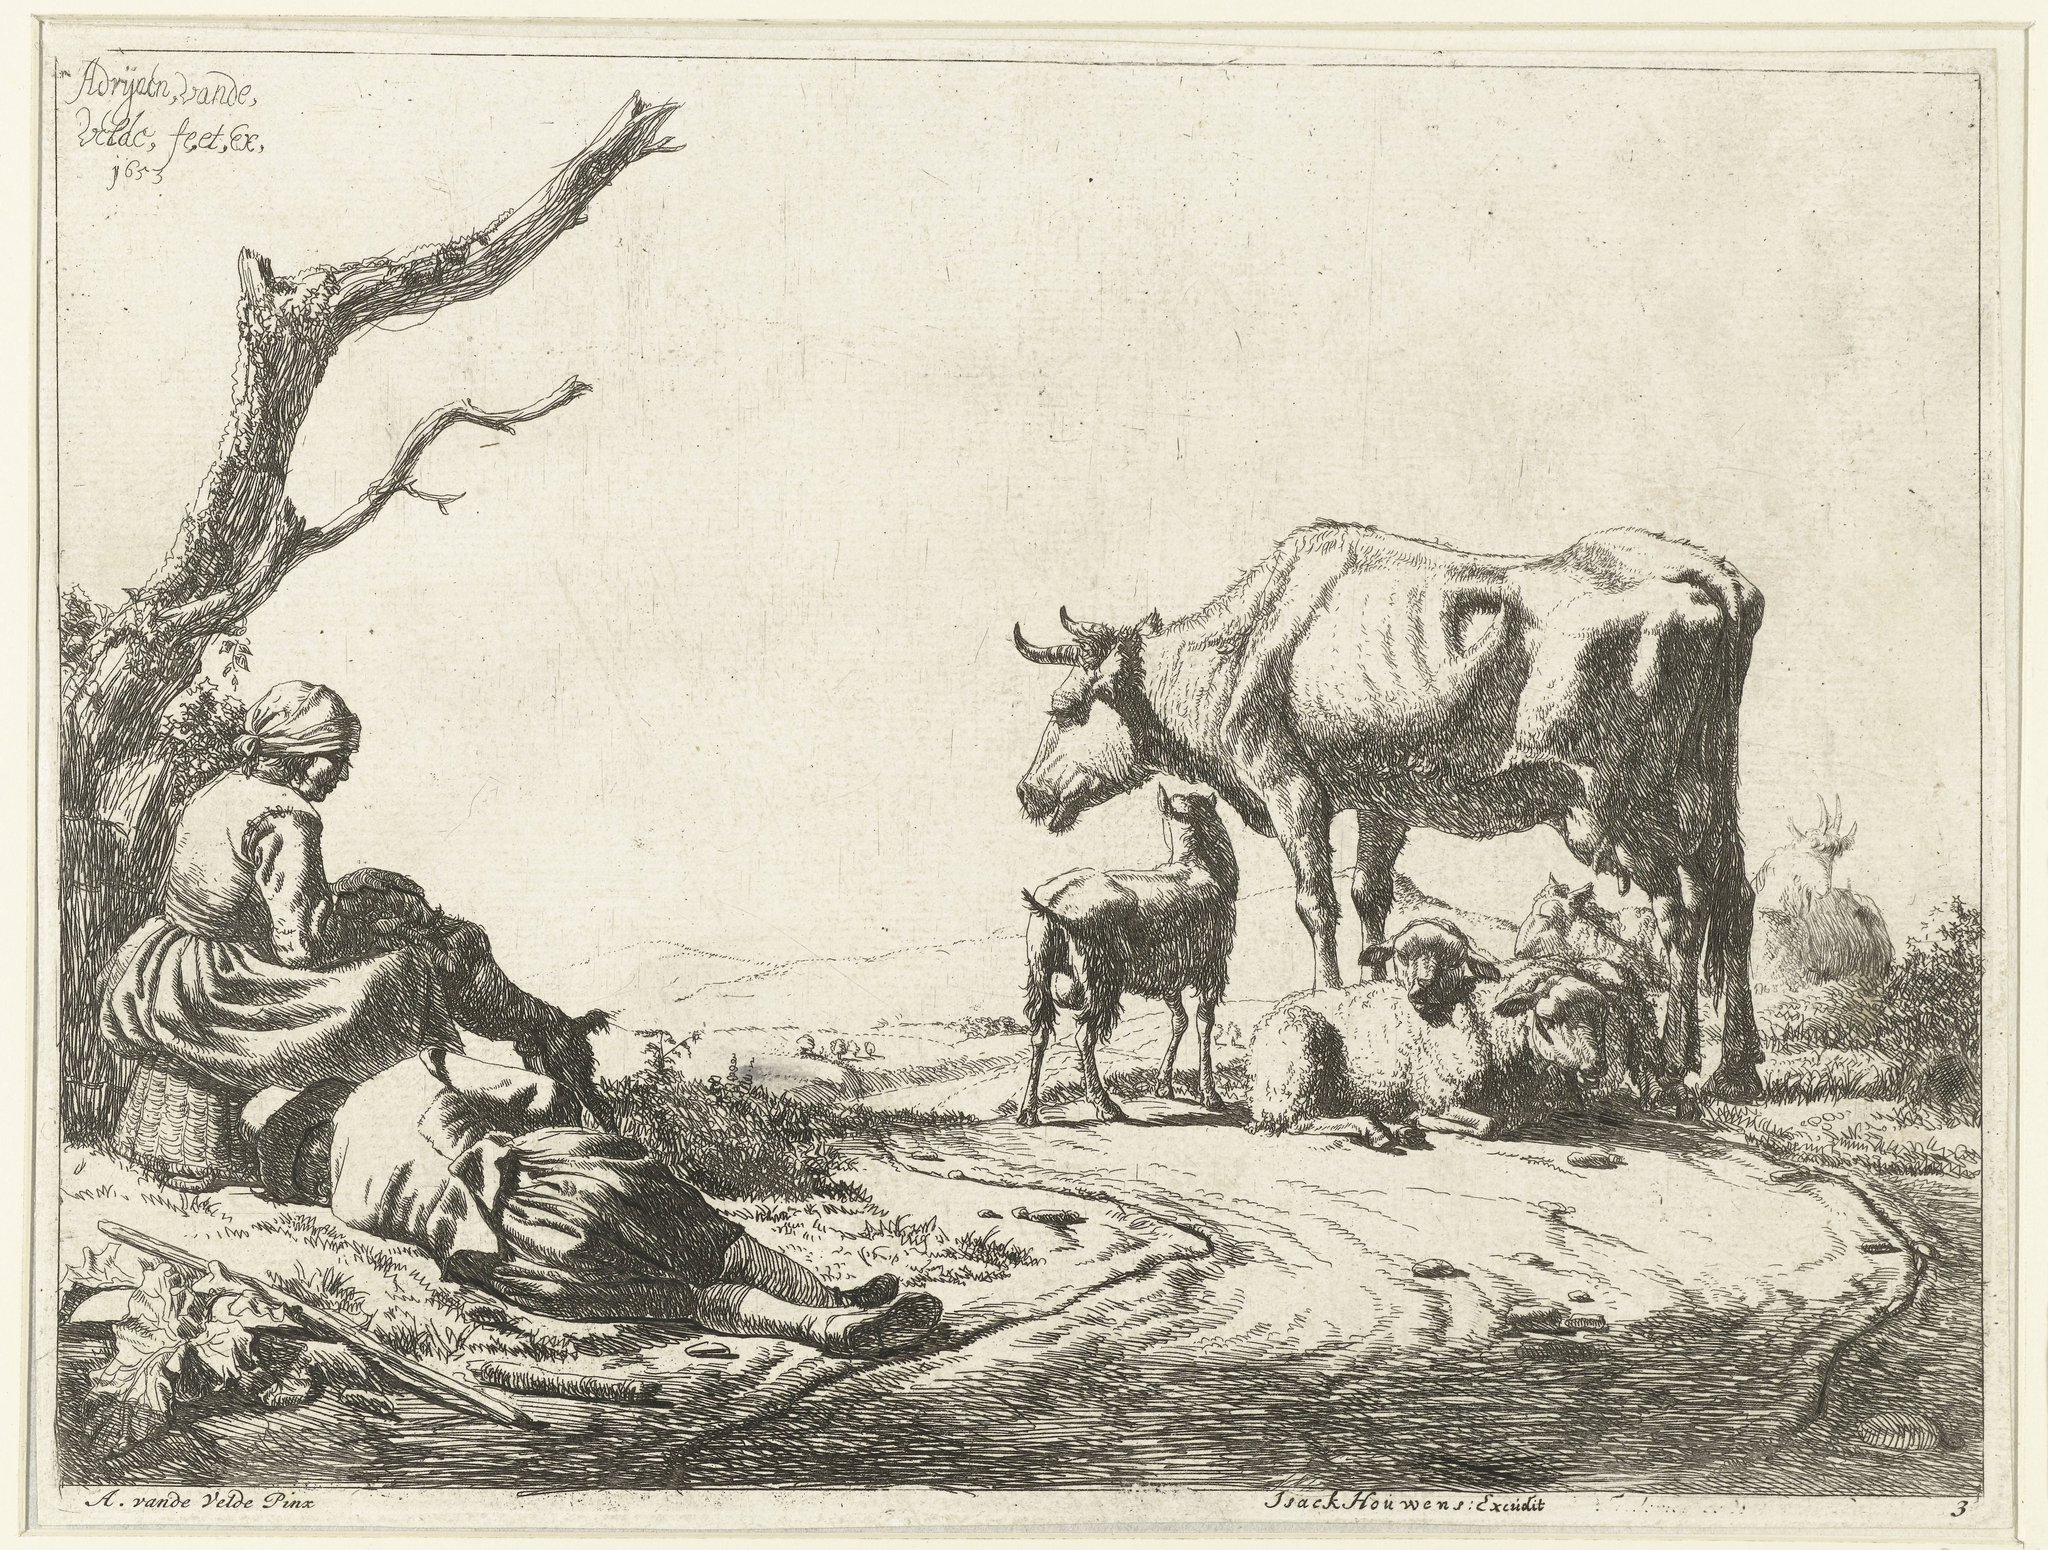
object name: print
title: Herder en herderin met vee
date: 1653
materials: paper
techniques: engraving, etching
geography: amsterdam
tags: cow, herding, herdsman, herdswoman, shepherd, shepherdess, cowherd, etc., sheep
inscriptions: collector's mark: Lugt 2229a, collector's mark: Lugt 1293